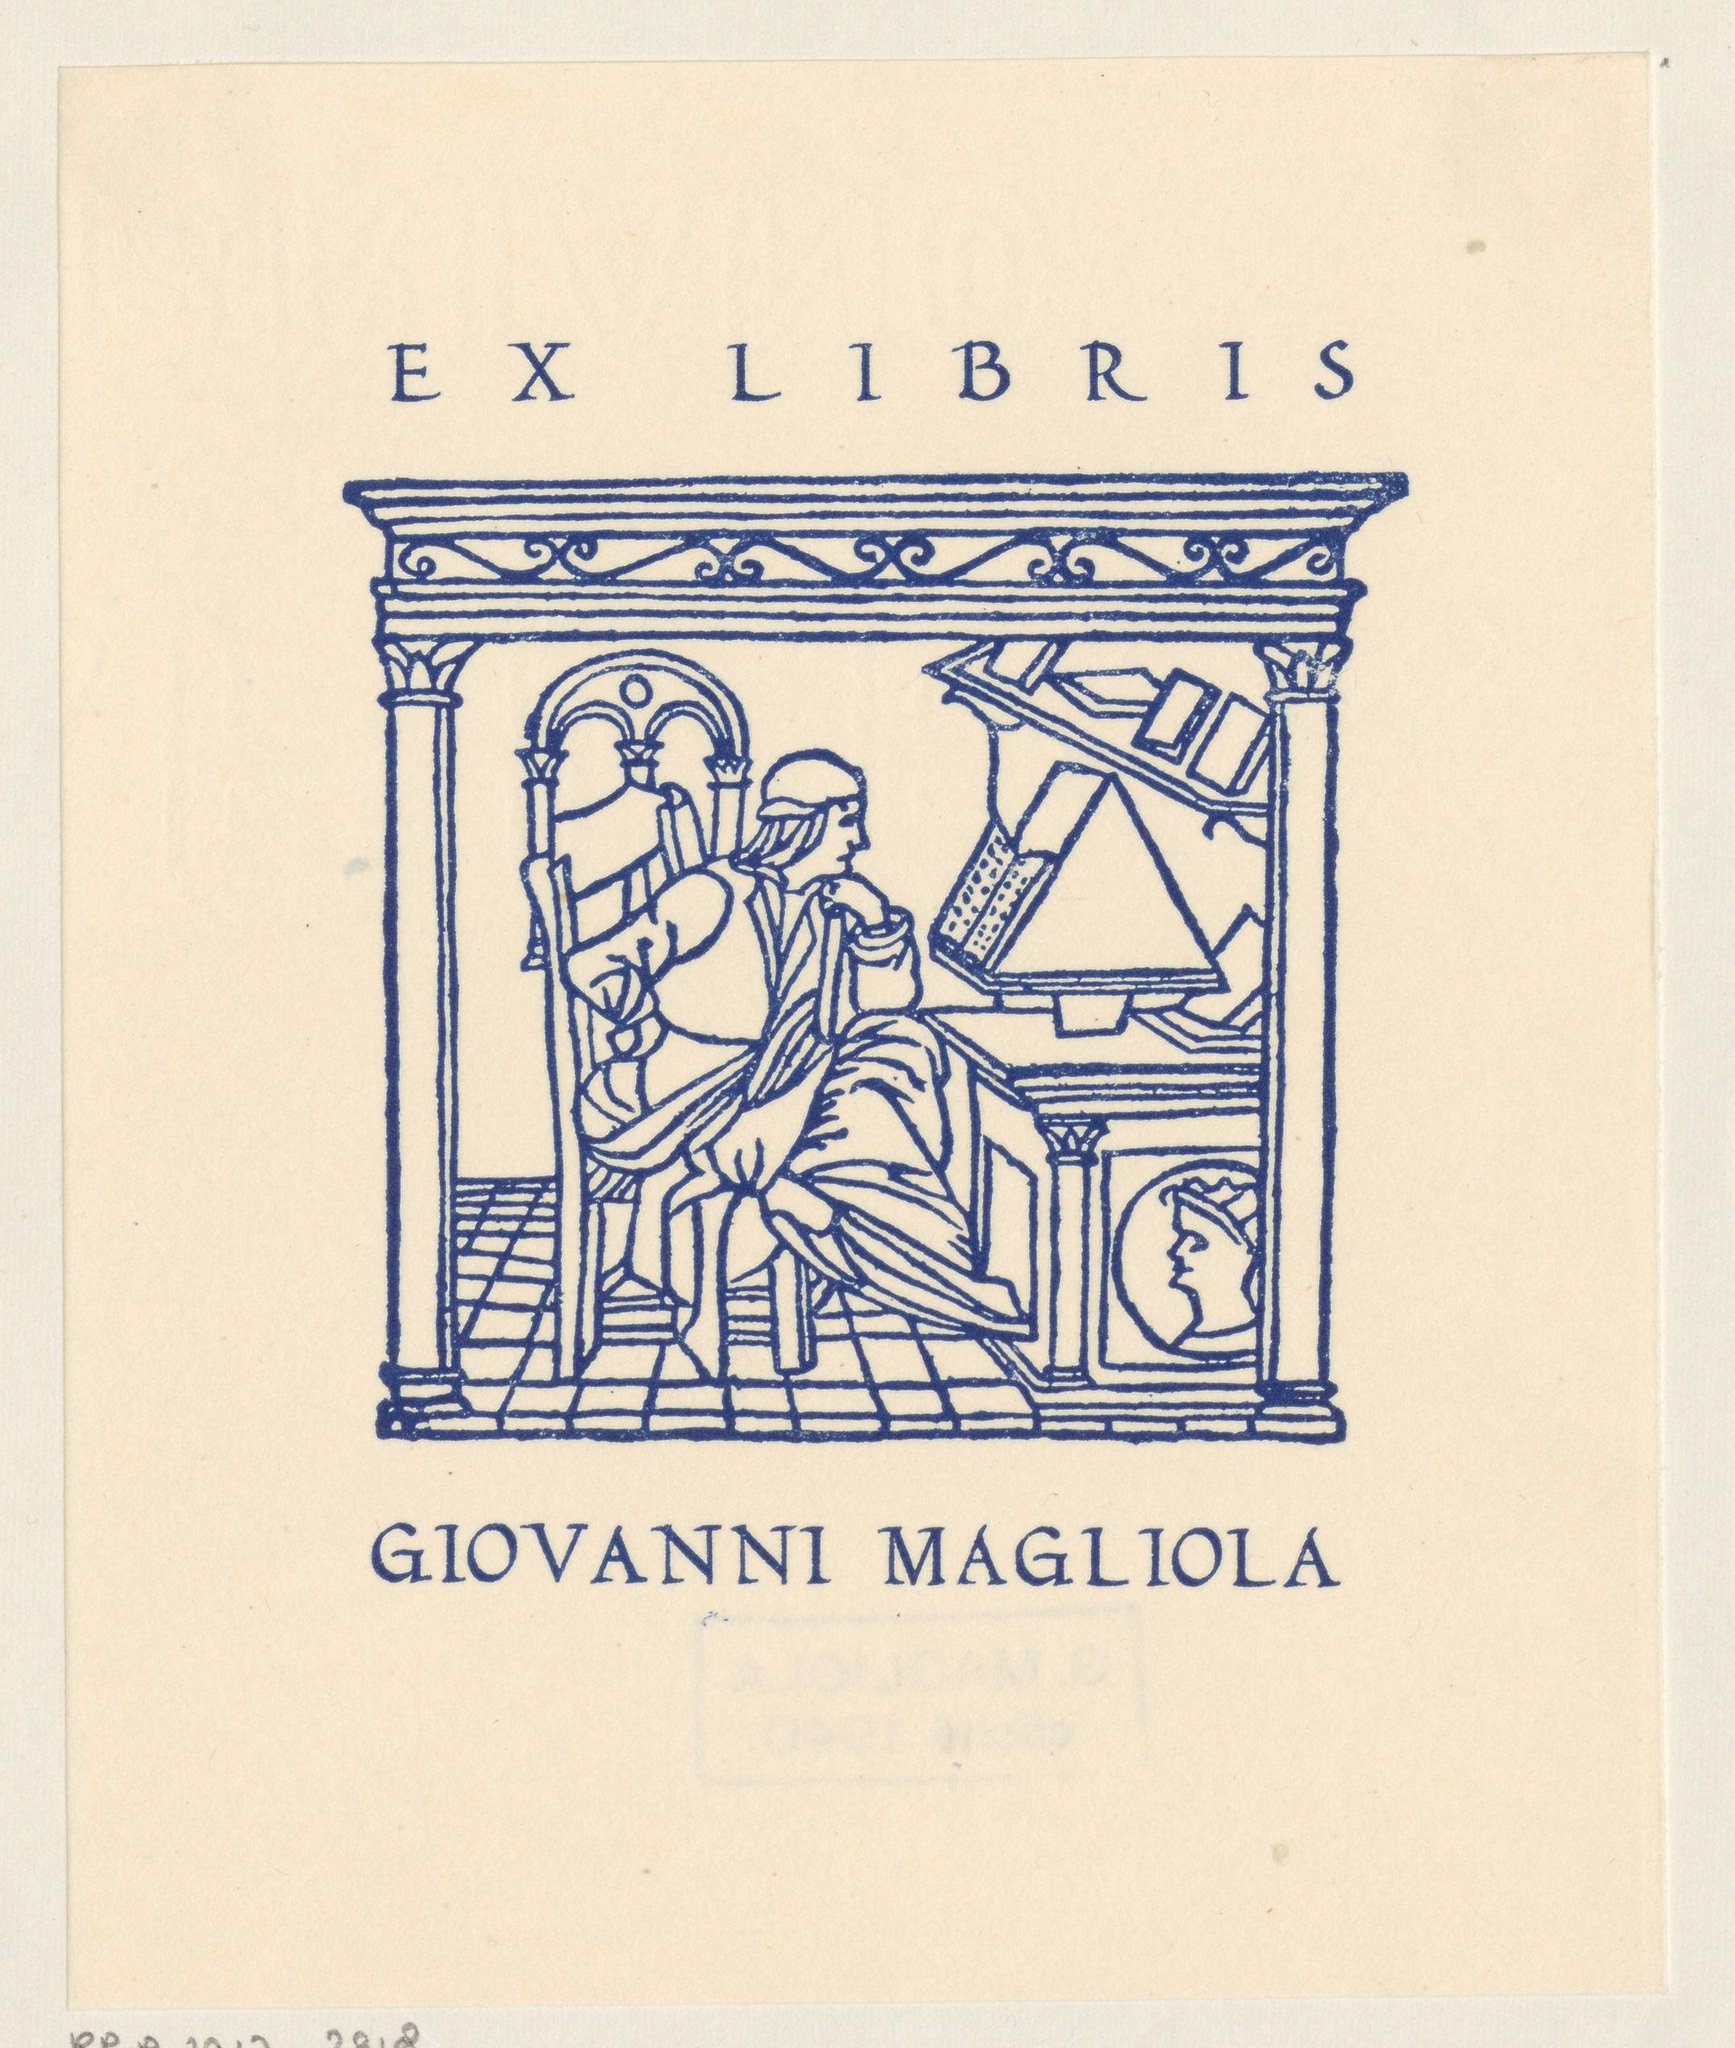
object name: bookplate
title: Ex libris van Giovanni Magliola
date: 1940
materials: paper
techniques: printing block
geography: italy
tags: giovanni magliola, reading, historical costume, study; 'studiolo'; library, book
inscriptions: workshop stamp: ‘G. Magliola / cliché 1940’